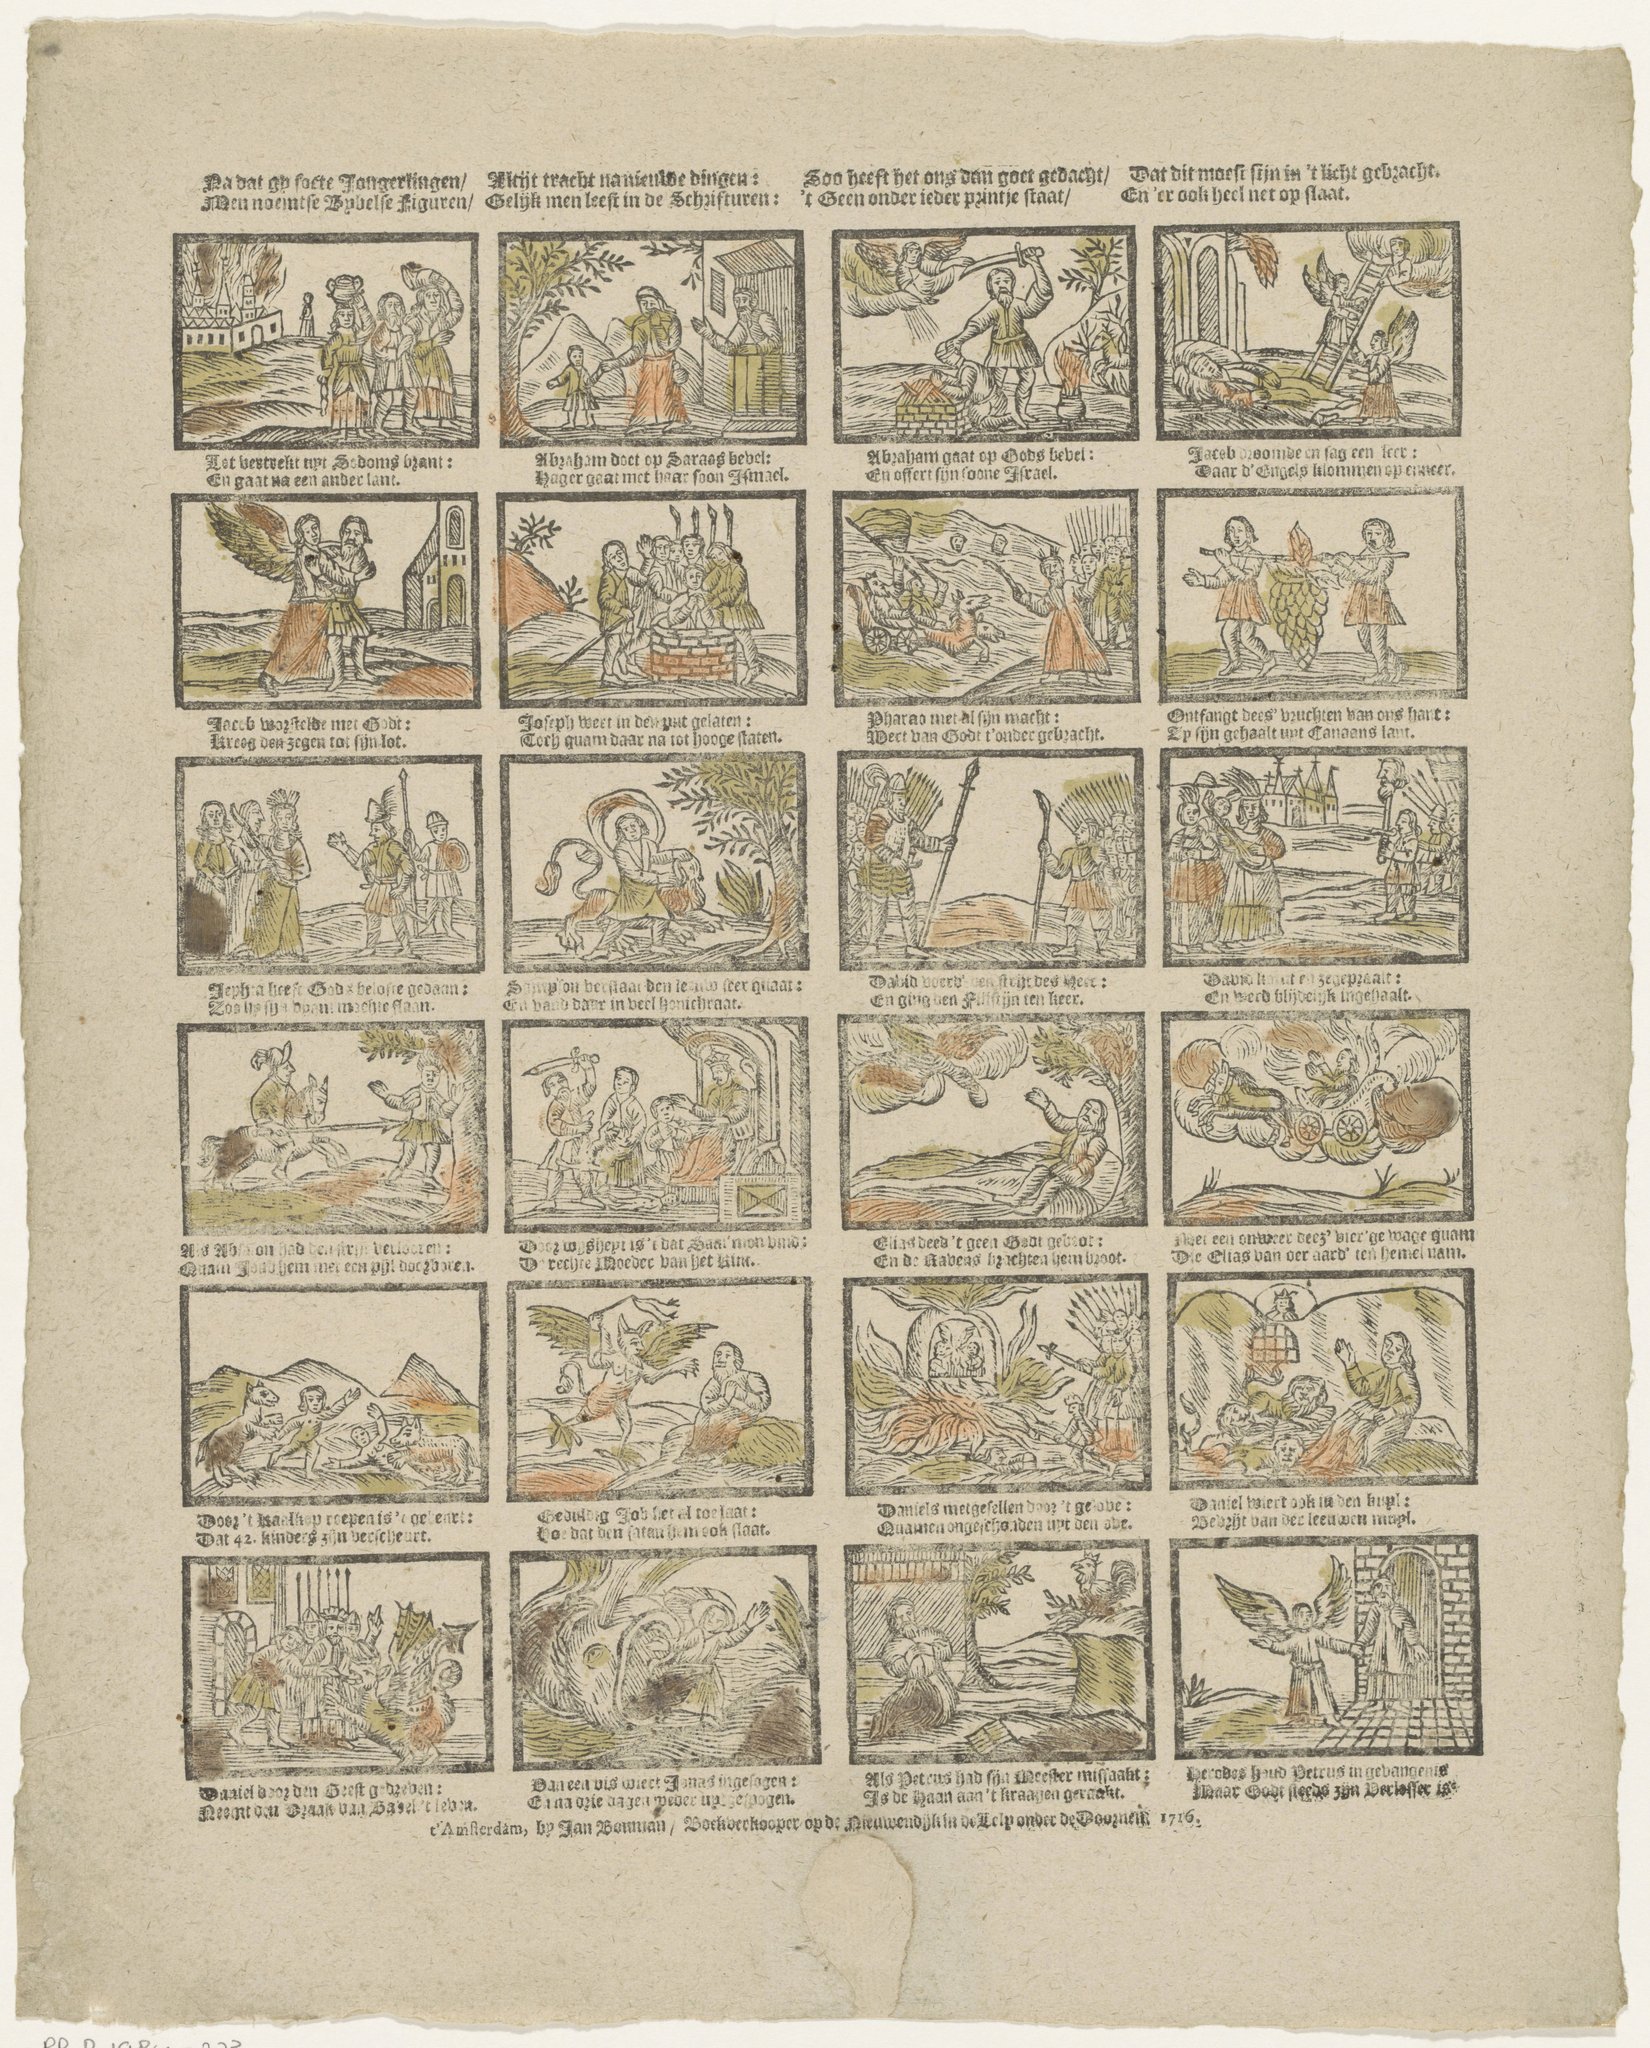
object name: print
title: Na dat gij soete jongelingen / Altijt tracht na nieuwe dingen (...)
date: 1716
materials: paper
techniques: colour, letterpress printing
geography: amsterdam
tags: new testament, old testament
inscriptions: collector's mark: Lugt 2760, collector's mark: Lugt 2228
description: Blad met 24 voorstellingen van verhalen uit de Bijbel, waaronder Abraham die Isaak offert, Jona en de walvis en de bevrijding van Petrus. Onder elke voorstelling een tweeregelig vers.